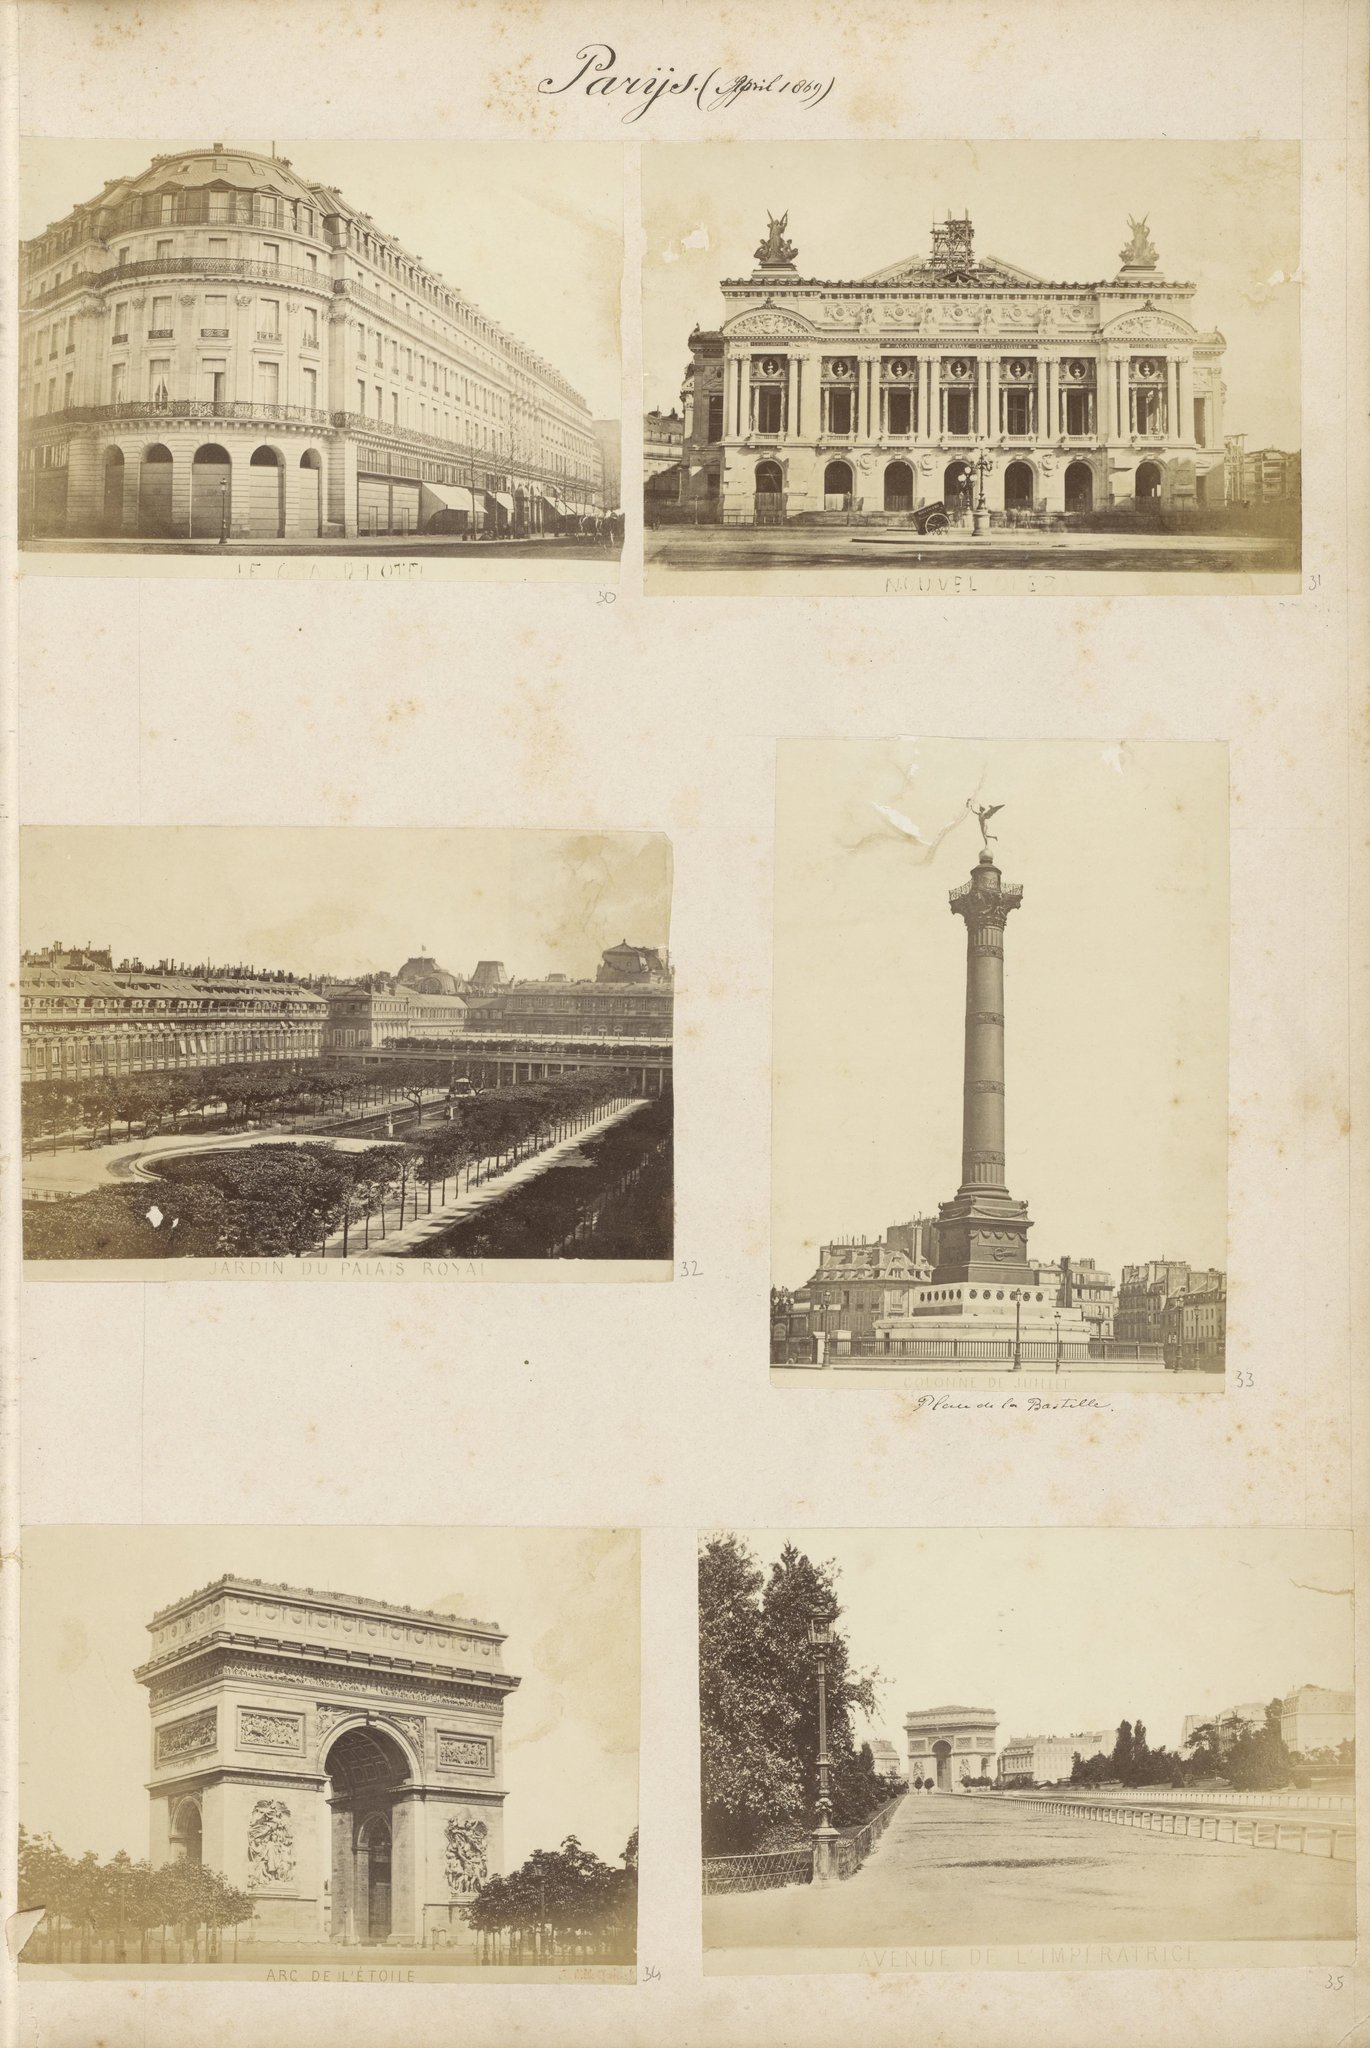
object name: album leaf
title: Arc de l'Étoile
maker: Anonymous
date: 1804-1869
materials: paper, photographic support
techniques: albumen print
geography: paris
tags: triumphal arch, paris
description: Onderdeel van Fotoalbum van Robert Daniel Crommelin (1841-1907).